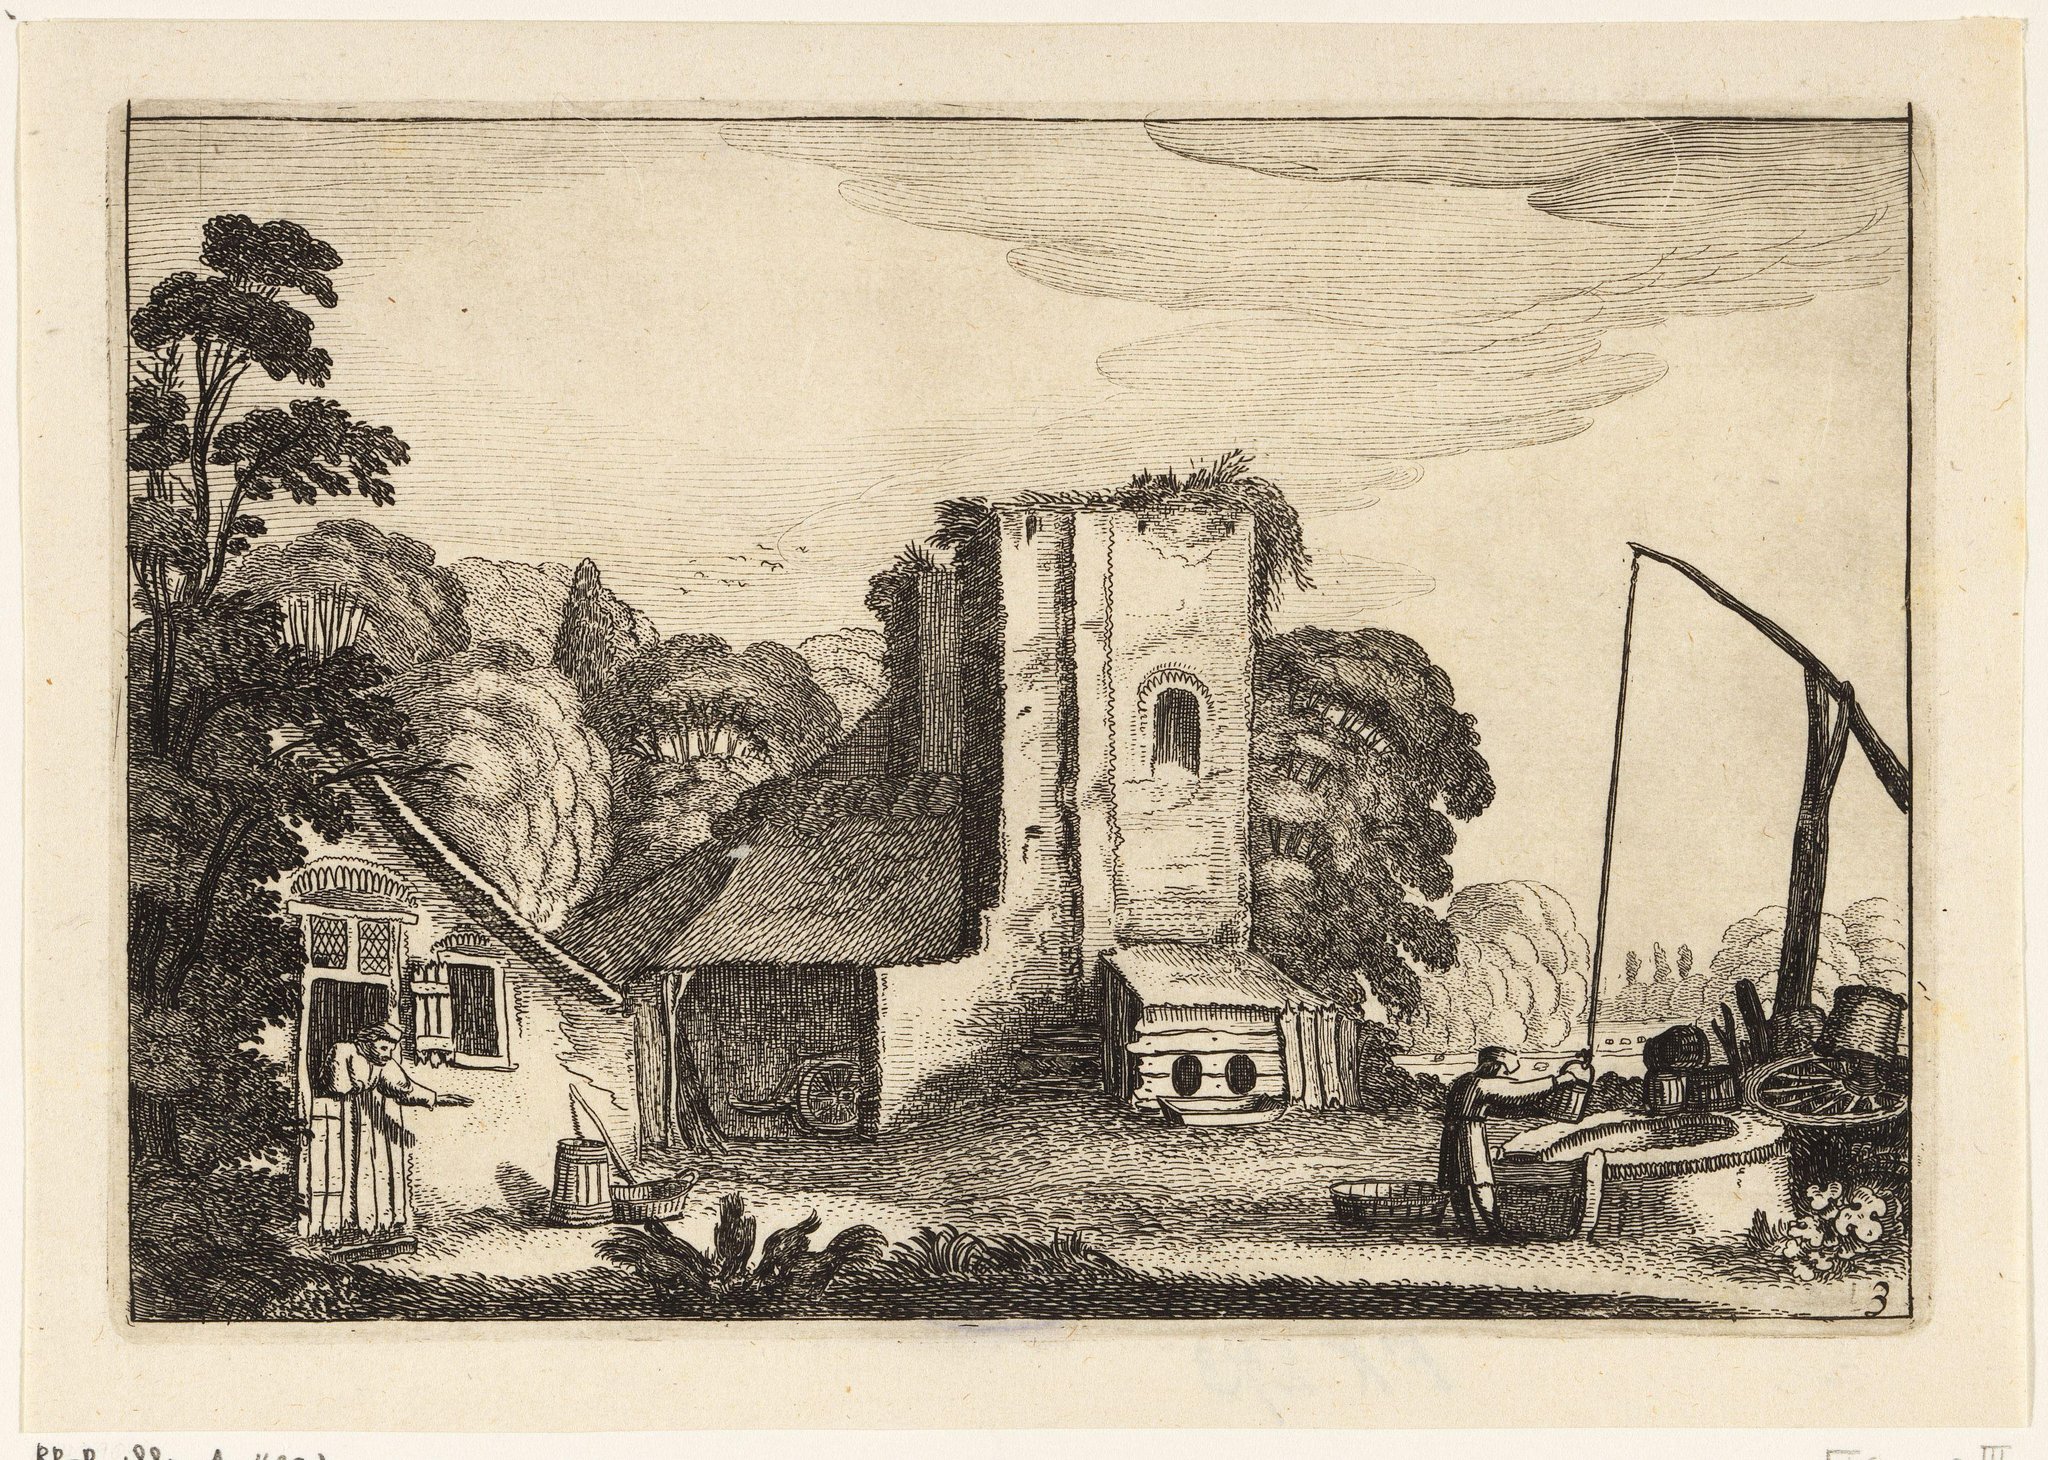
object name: print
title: Amenissimae aliquot requculae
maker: jan van de velde (ii)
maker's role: draughtsman, painter, print maker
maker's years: 1593-1641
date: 1616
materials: paper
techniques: etching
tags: well, landscape with ruins, farm or solitary house in landscape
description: Oorspronkelijk vormden de eerste staten van de prenten een serie bestaande uit twee delen van elk 26 prenten. De latere staten vormden een serie van vijf delen van elk twaalf prenten.